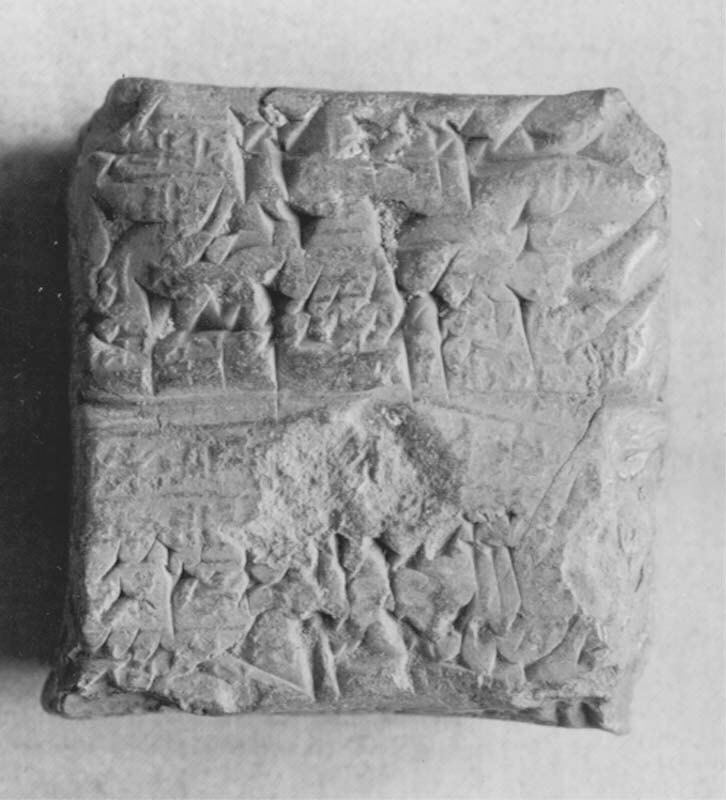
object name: cuneiform tablet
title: Cuneiform tablet impressed with cylinder seal: tax receipt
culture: babylonian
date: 1634 BCE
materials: clay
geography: mesopotamia